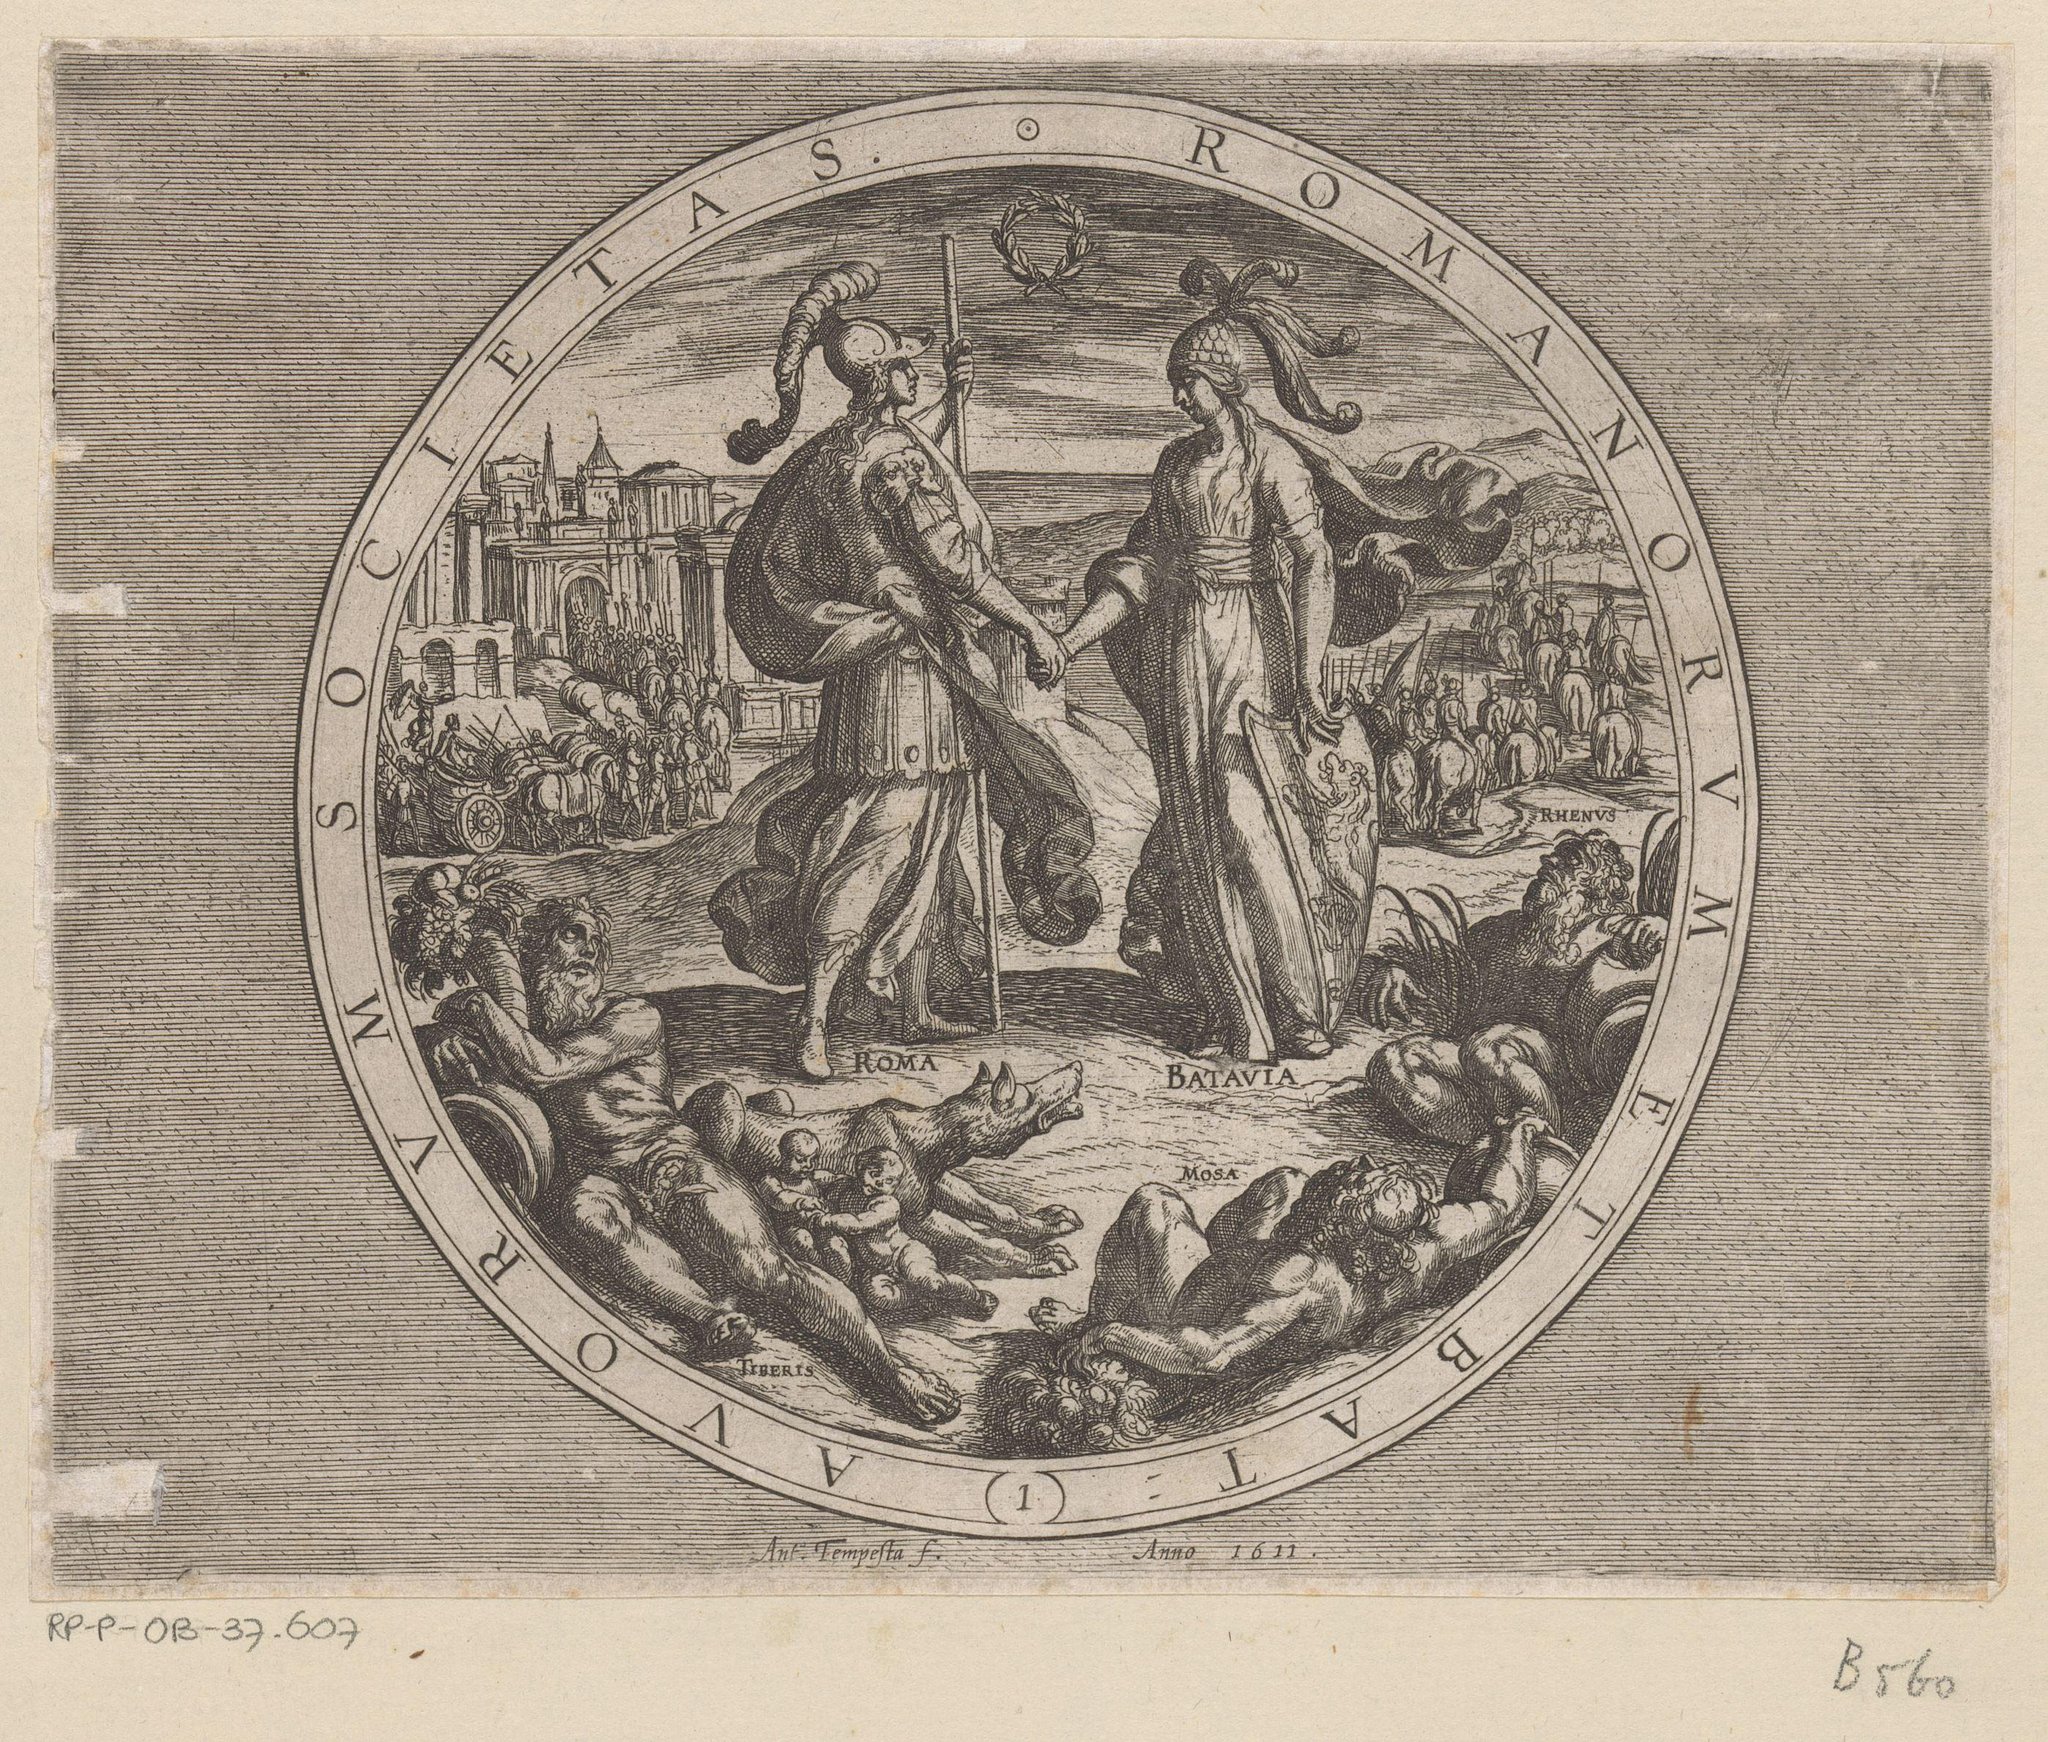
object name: print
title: Roma en Batavia schudden elkaar de hand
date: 1611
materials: paper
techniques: etching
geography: southern netherlands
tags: personification of a city, town-patron(ess), extinct, 'historical' peoples (with name), rome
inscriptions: collector's mark: Lugt 240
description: De personificaties Roma en Batavia schudden elkaar de hand. Op de voorgrond liggen de personificaties van de rivieren de Tiber, de Maas en de Rijn en de Lupa Capitolina die de tweeling Romulus en Remus zoogt.